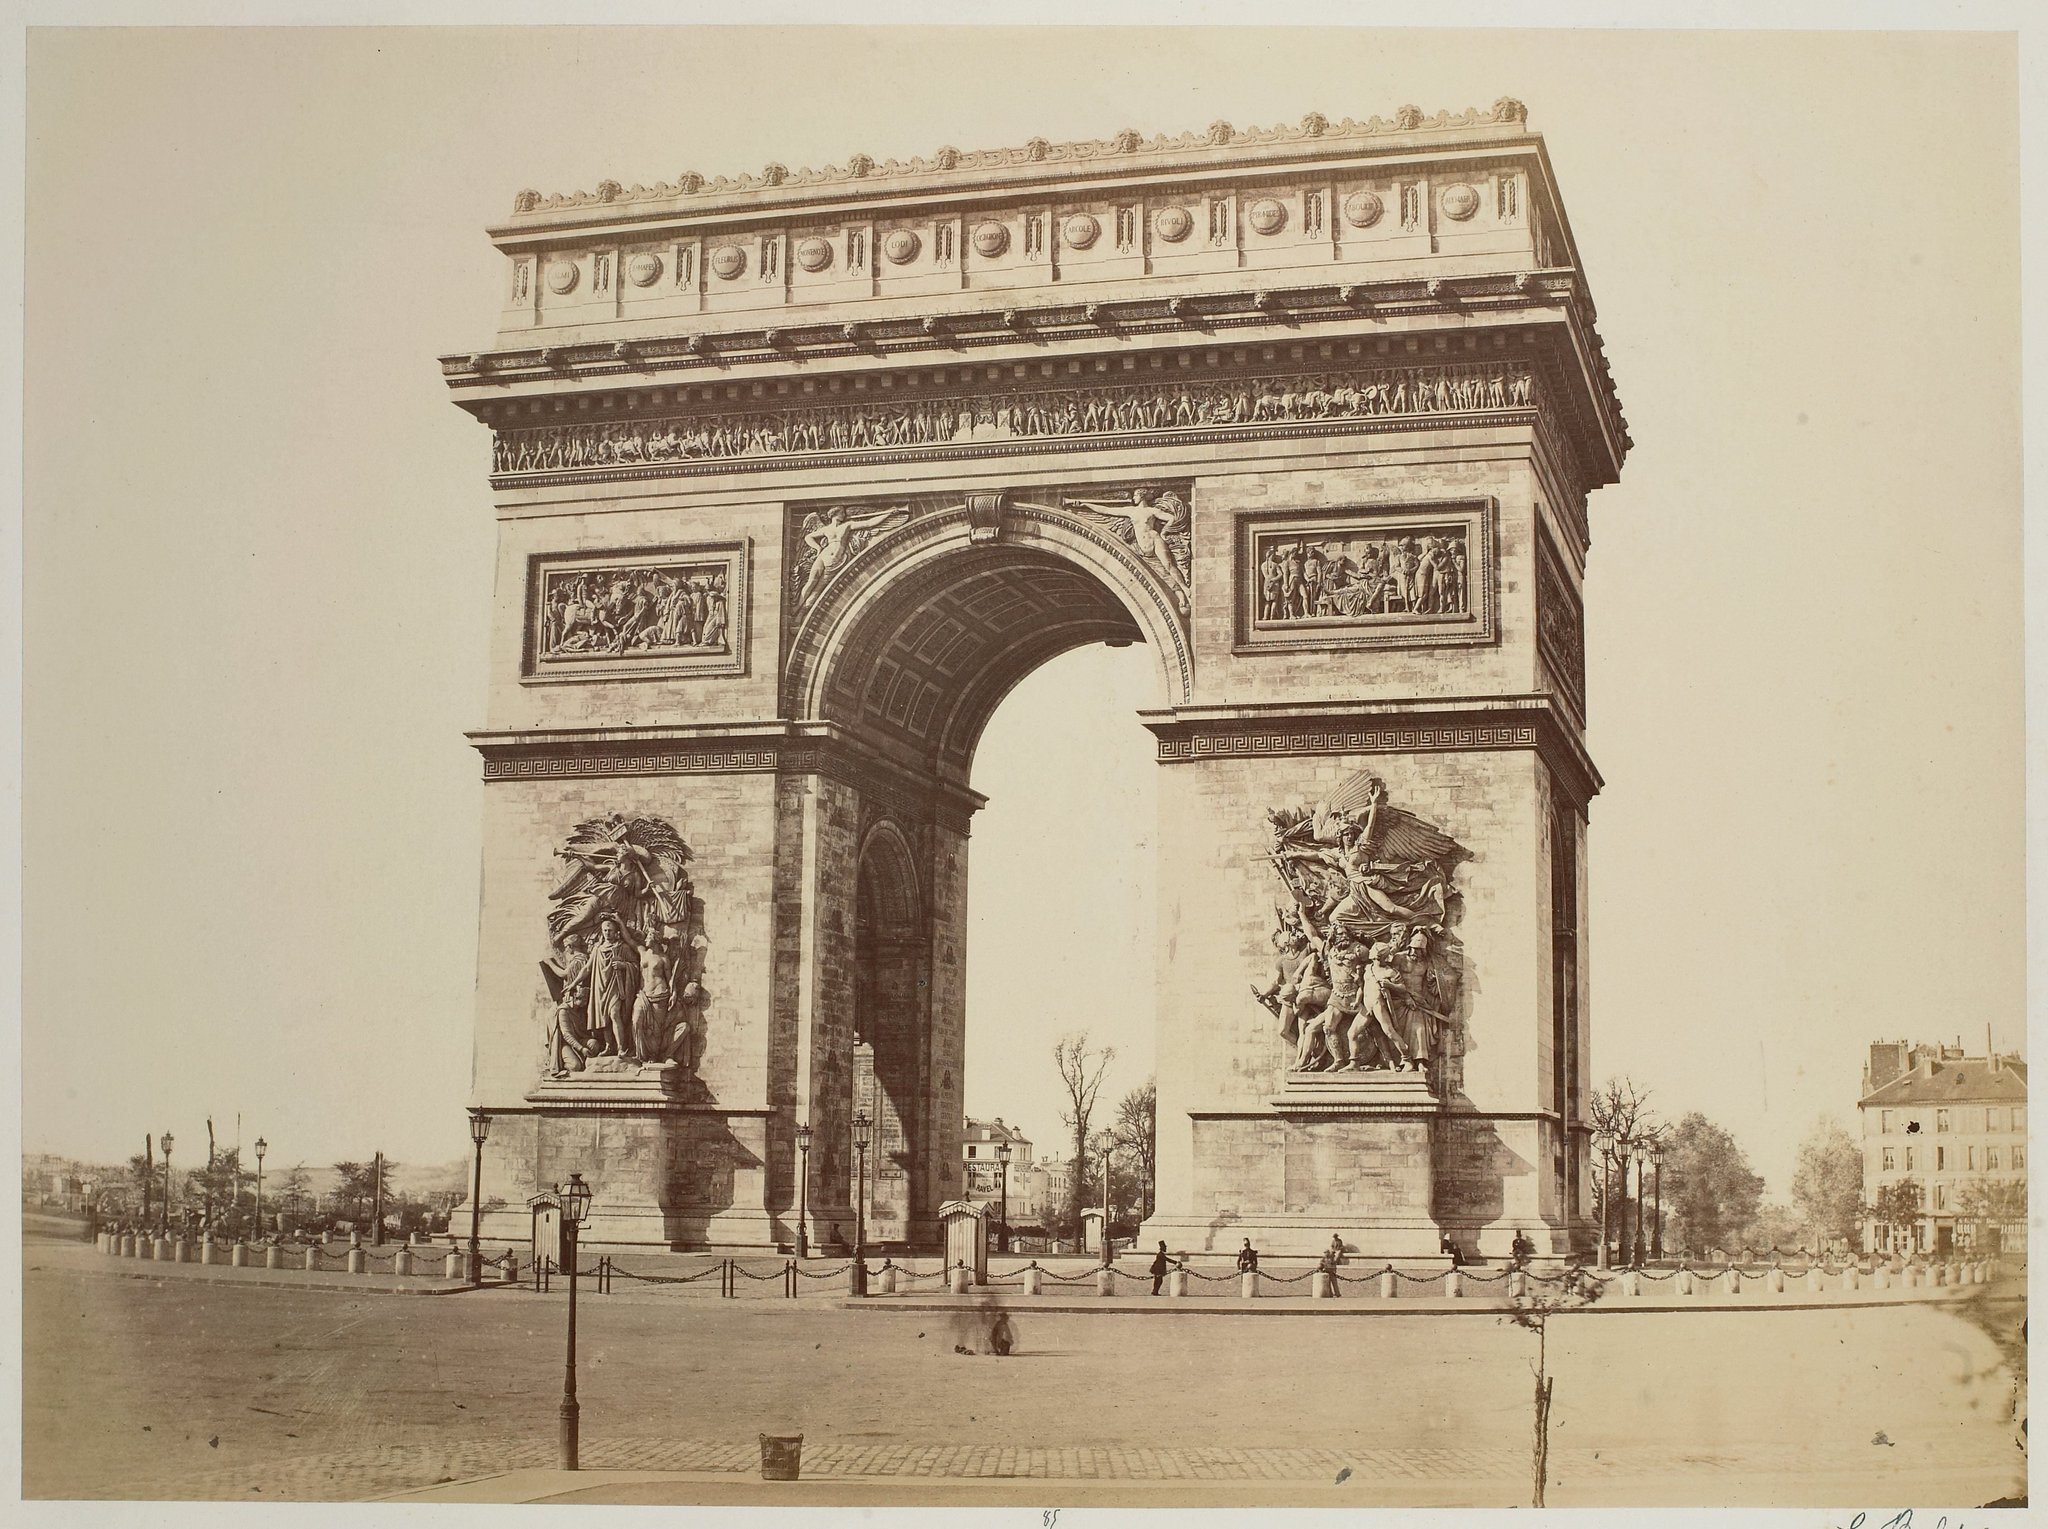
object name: photograph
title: Arc de Triomphe te Parijs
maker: édouard denis baldus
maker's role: fotograaf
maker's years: 1813-1889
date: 1855-1858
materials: cardboard, photographic support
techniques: albumen print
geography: france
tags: arc de triomphe